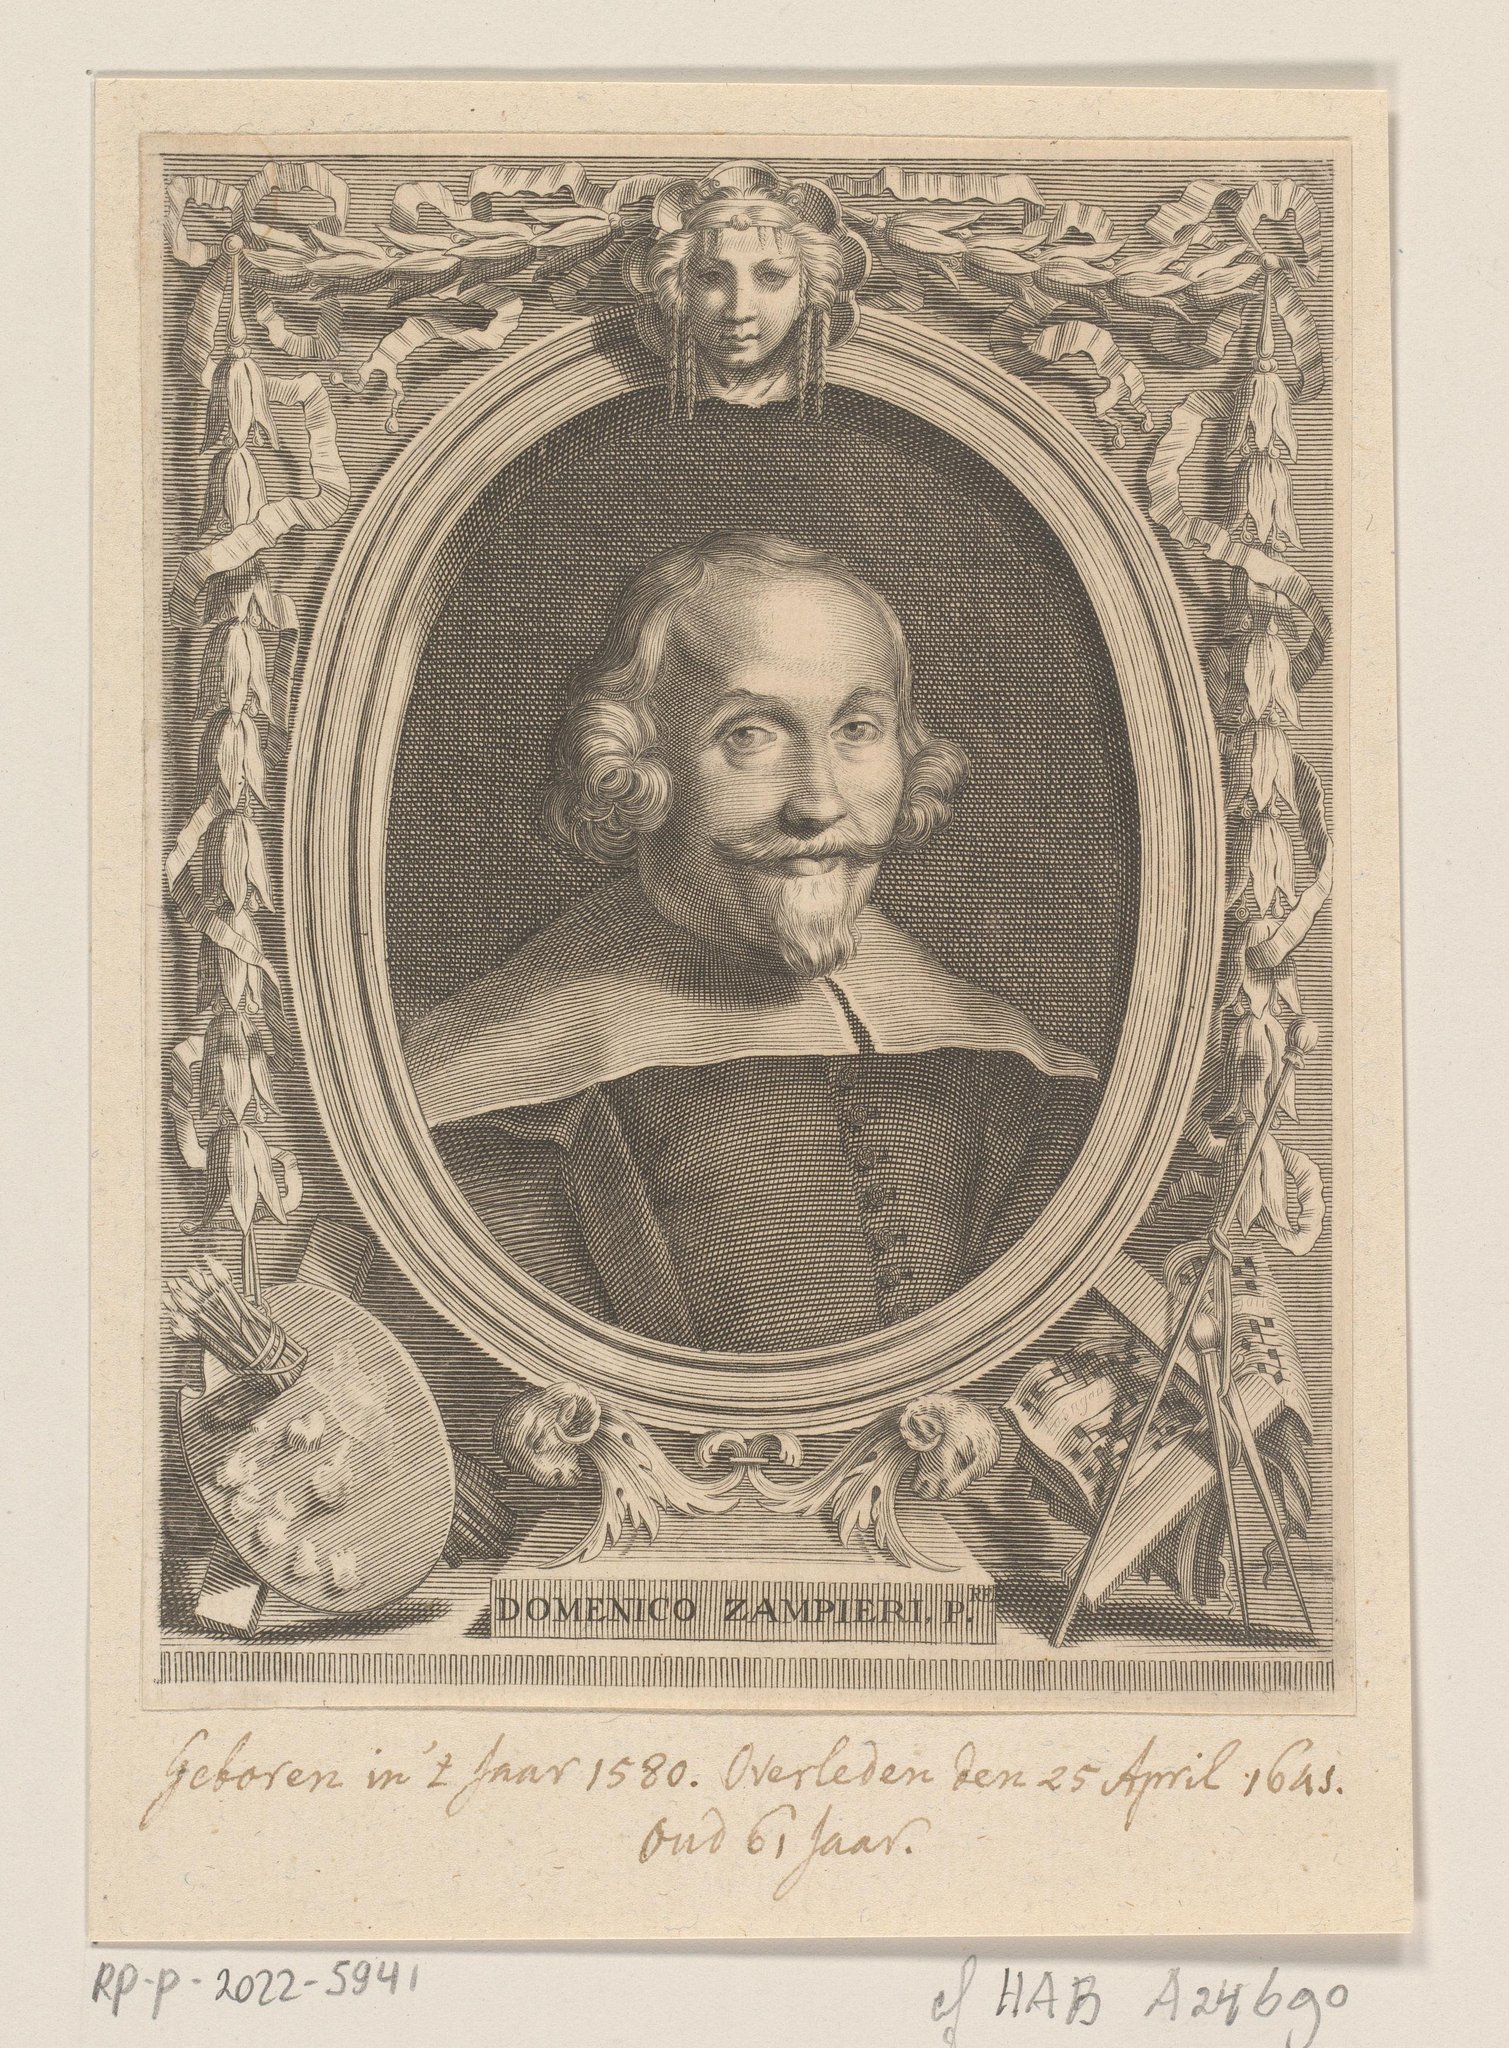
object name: print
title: Portret van Domenichino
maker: Anonymous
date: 1620-1700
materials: paper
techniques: engraving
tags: painter, draughtsman, domenichino, historical persons, portrait, self-portrait of painter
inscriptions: inscription: ‘Geboren in 't jaar 1580. Overleden den 25 April 1641. Oud 61 jaar.’